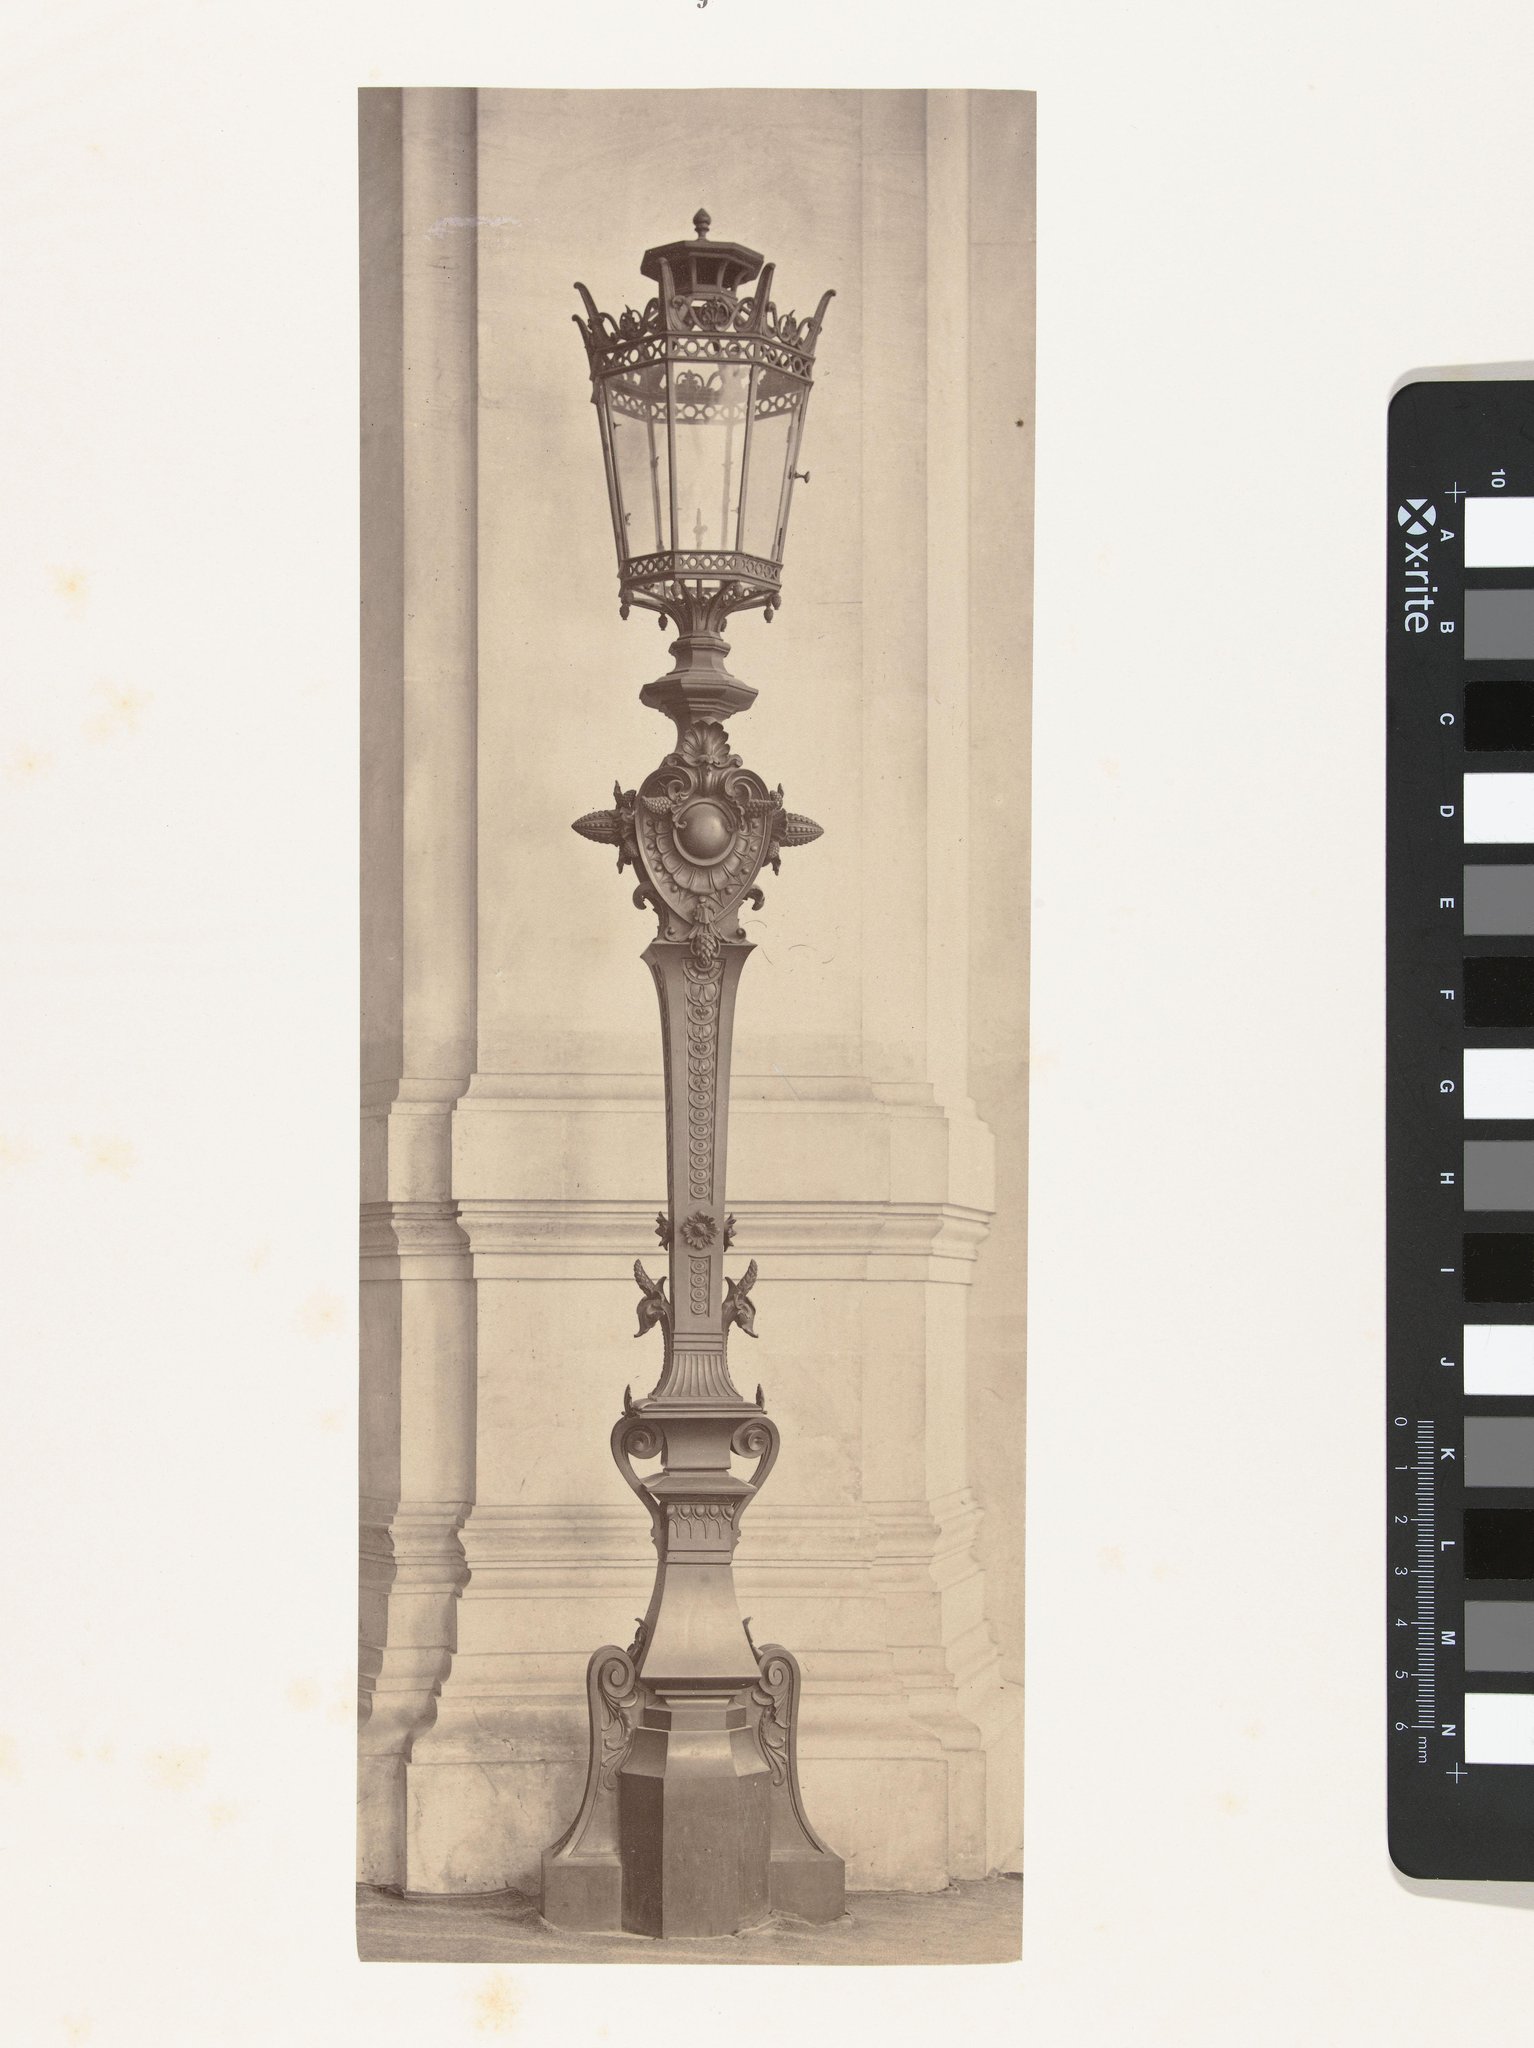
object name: photograph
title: 9. Le nouvel Opéra de Paris. Bronzes.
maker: louis-emile durandelle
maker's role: fotograaf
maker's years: 1839-1917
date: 1878-1881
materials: photographic support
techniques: albumen print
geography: paris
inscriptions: number: ‘9’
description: bij boek in Bibliotheek RMA, Zie Frizot, pp. 217-223, vgl G. Vicaire, Manuel de l'amateur de livres du XIXe siècle, vol. 3, column 870.